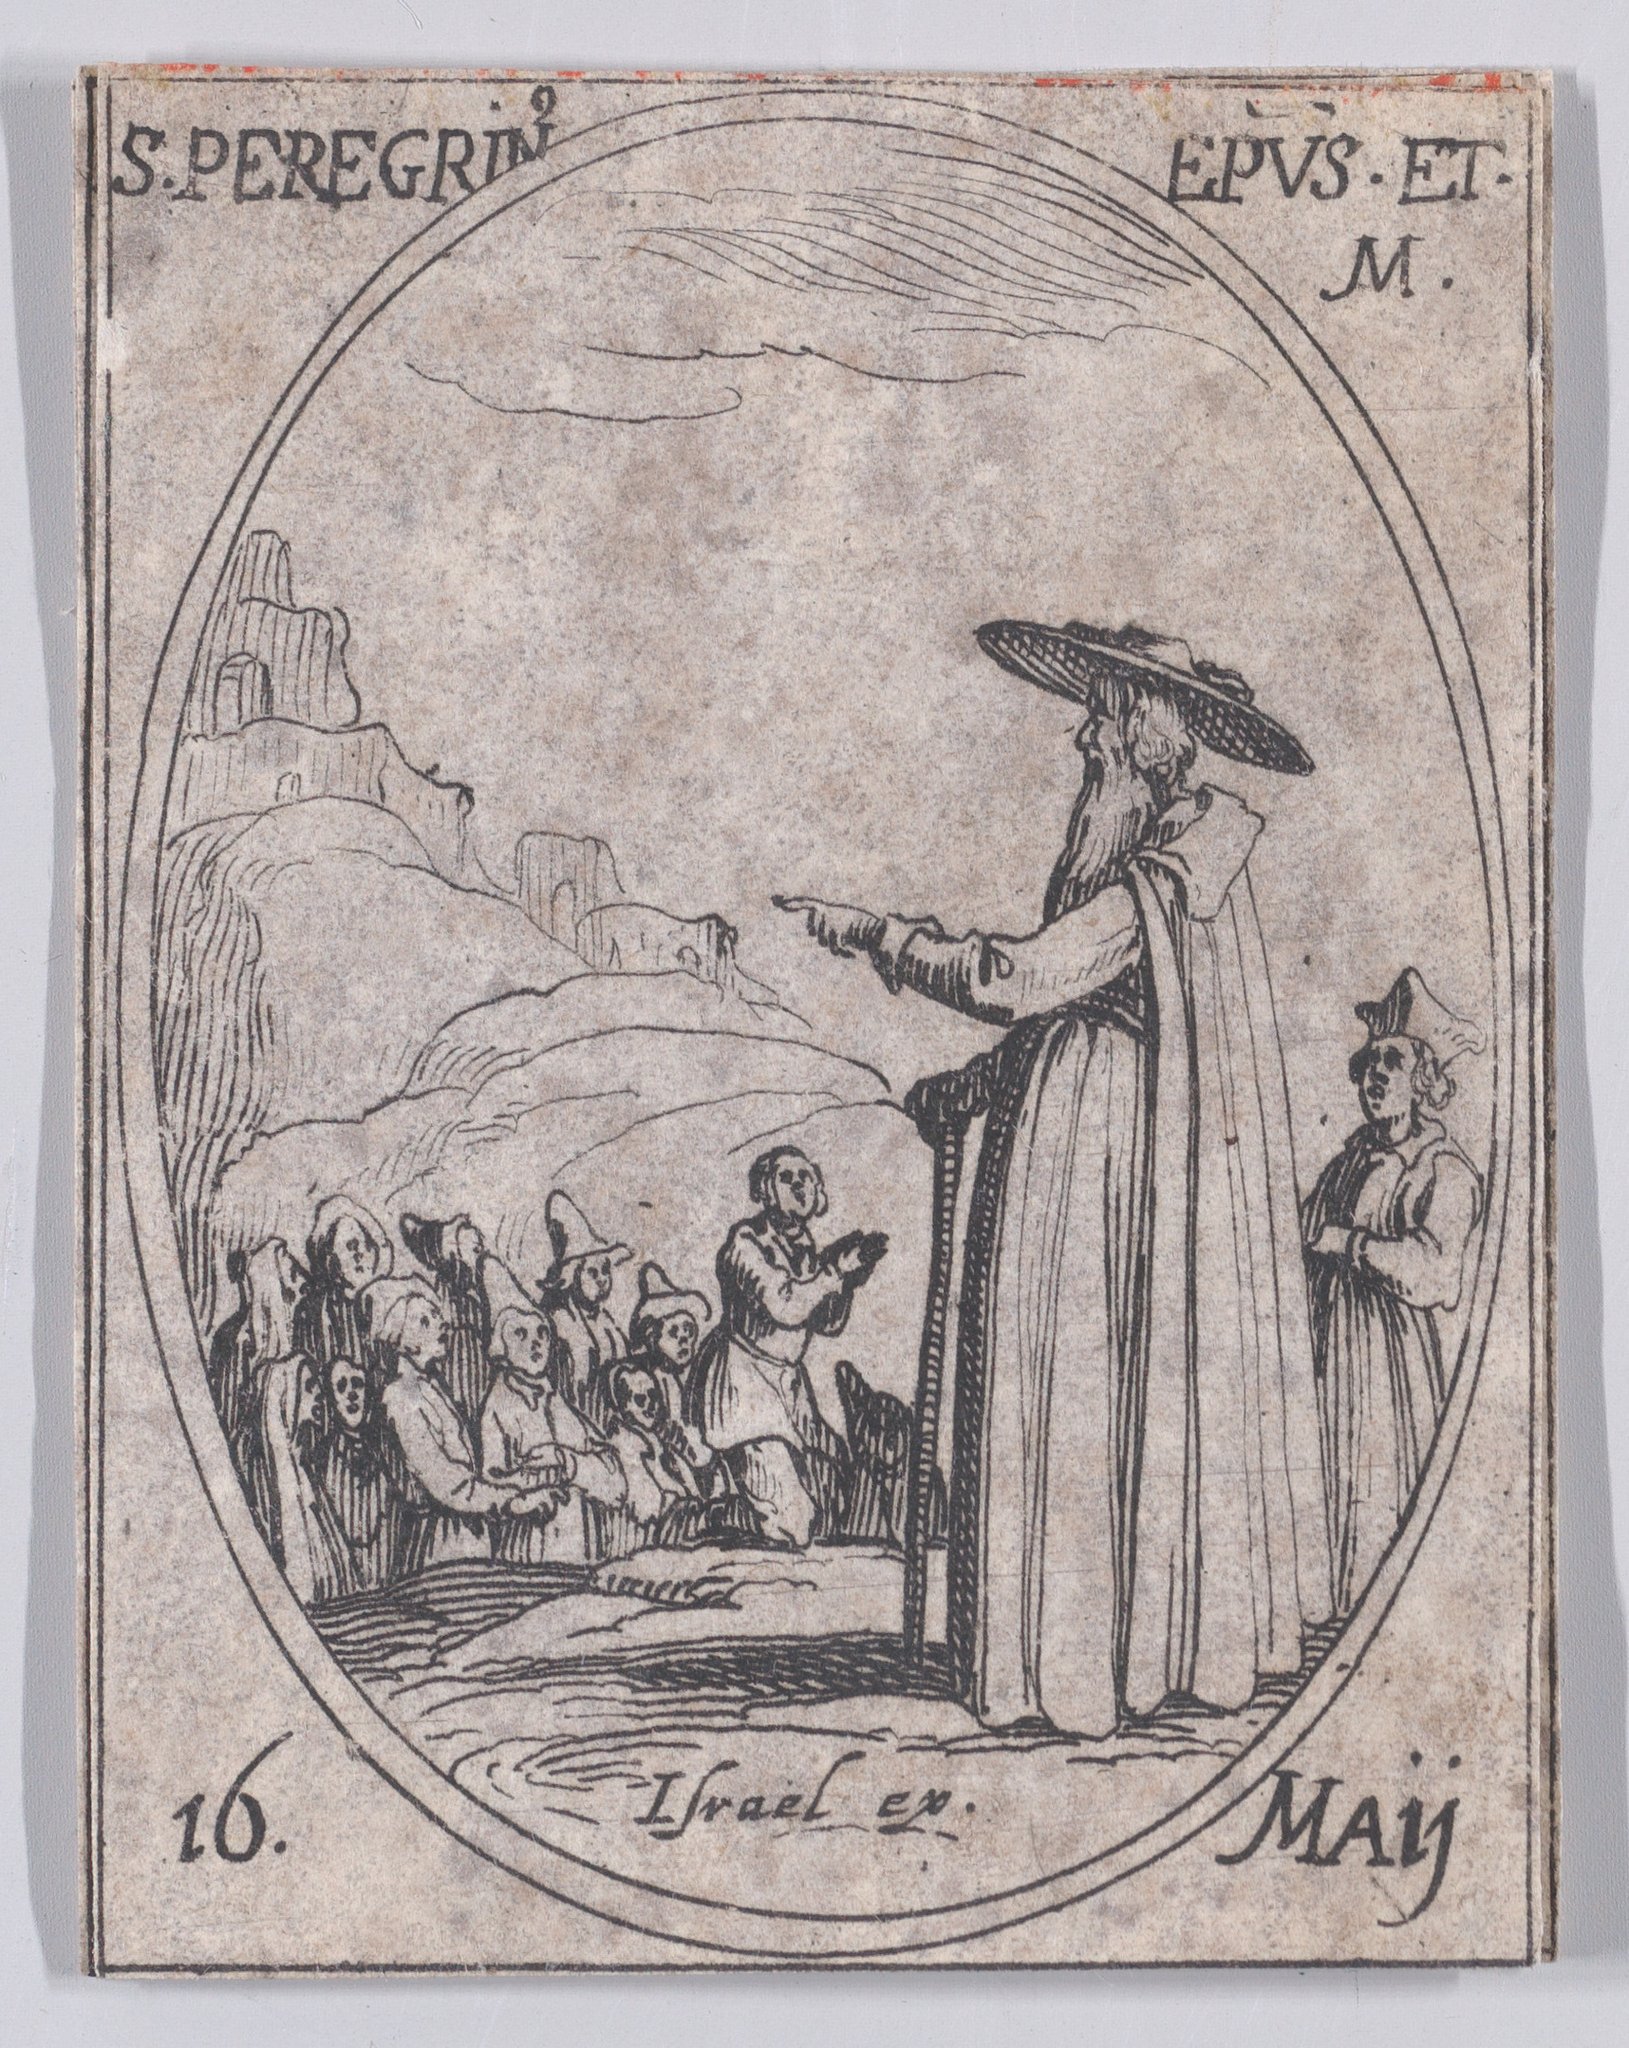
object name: print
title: S. Pèlerin, éveque et martyr (St. Pelerin, Bishop and Martyr), May 16th, from "Les Images De Tous Les Saincts et Saintes de L'Année" (Images of All of the Saints and Religious Events of the Year)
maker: jacques callot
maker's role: artist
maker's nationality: french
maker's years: 1592-1635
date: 1636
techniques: etching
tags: men,saints